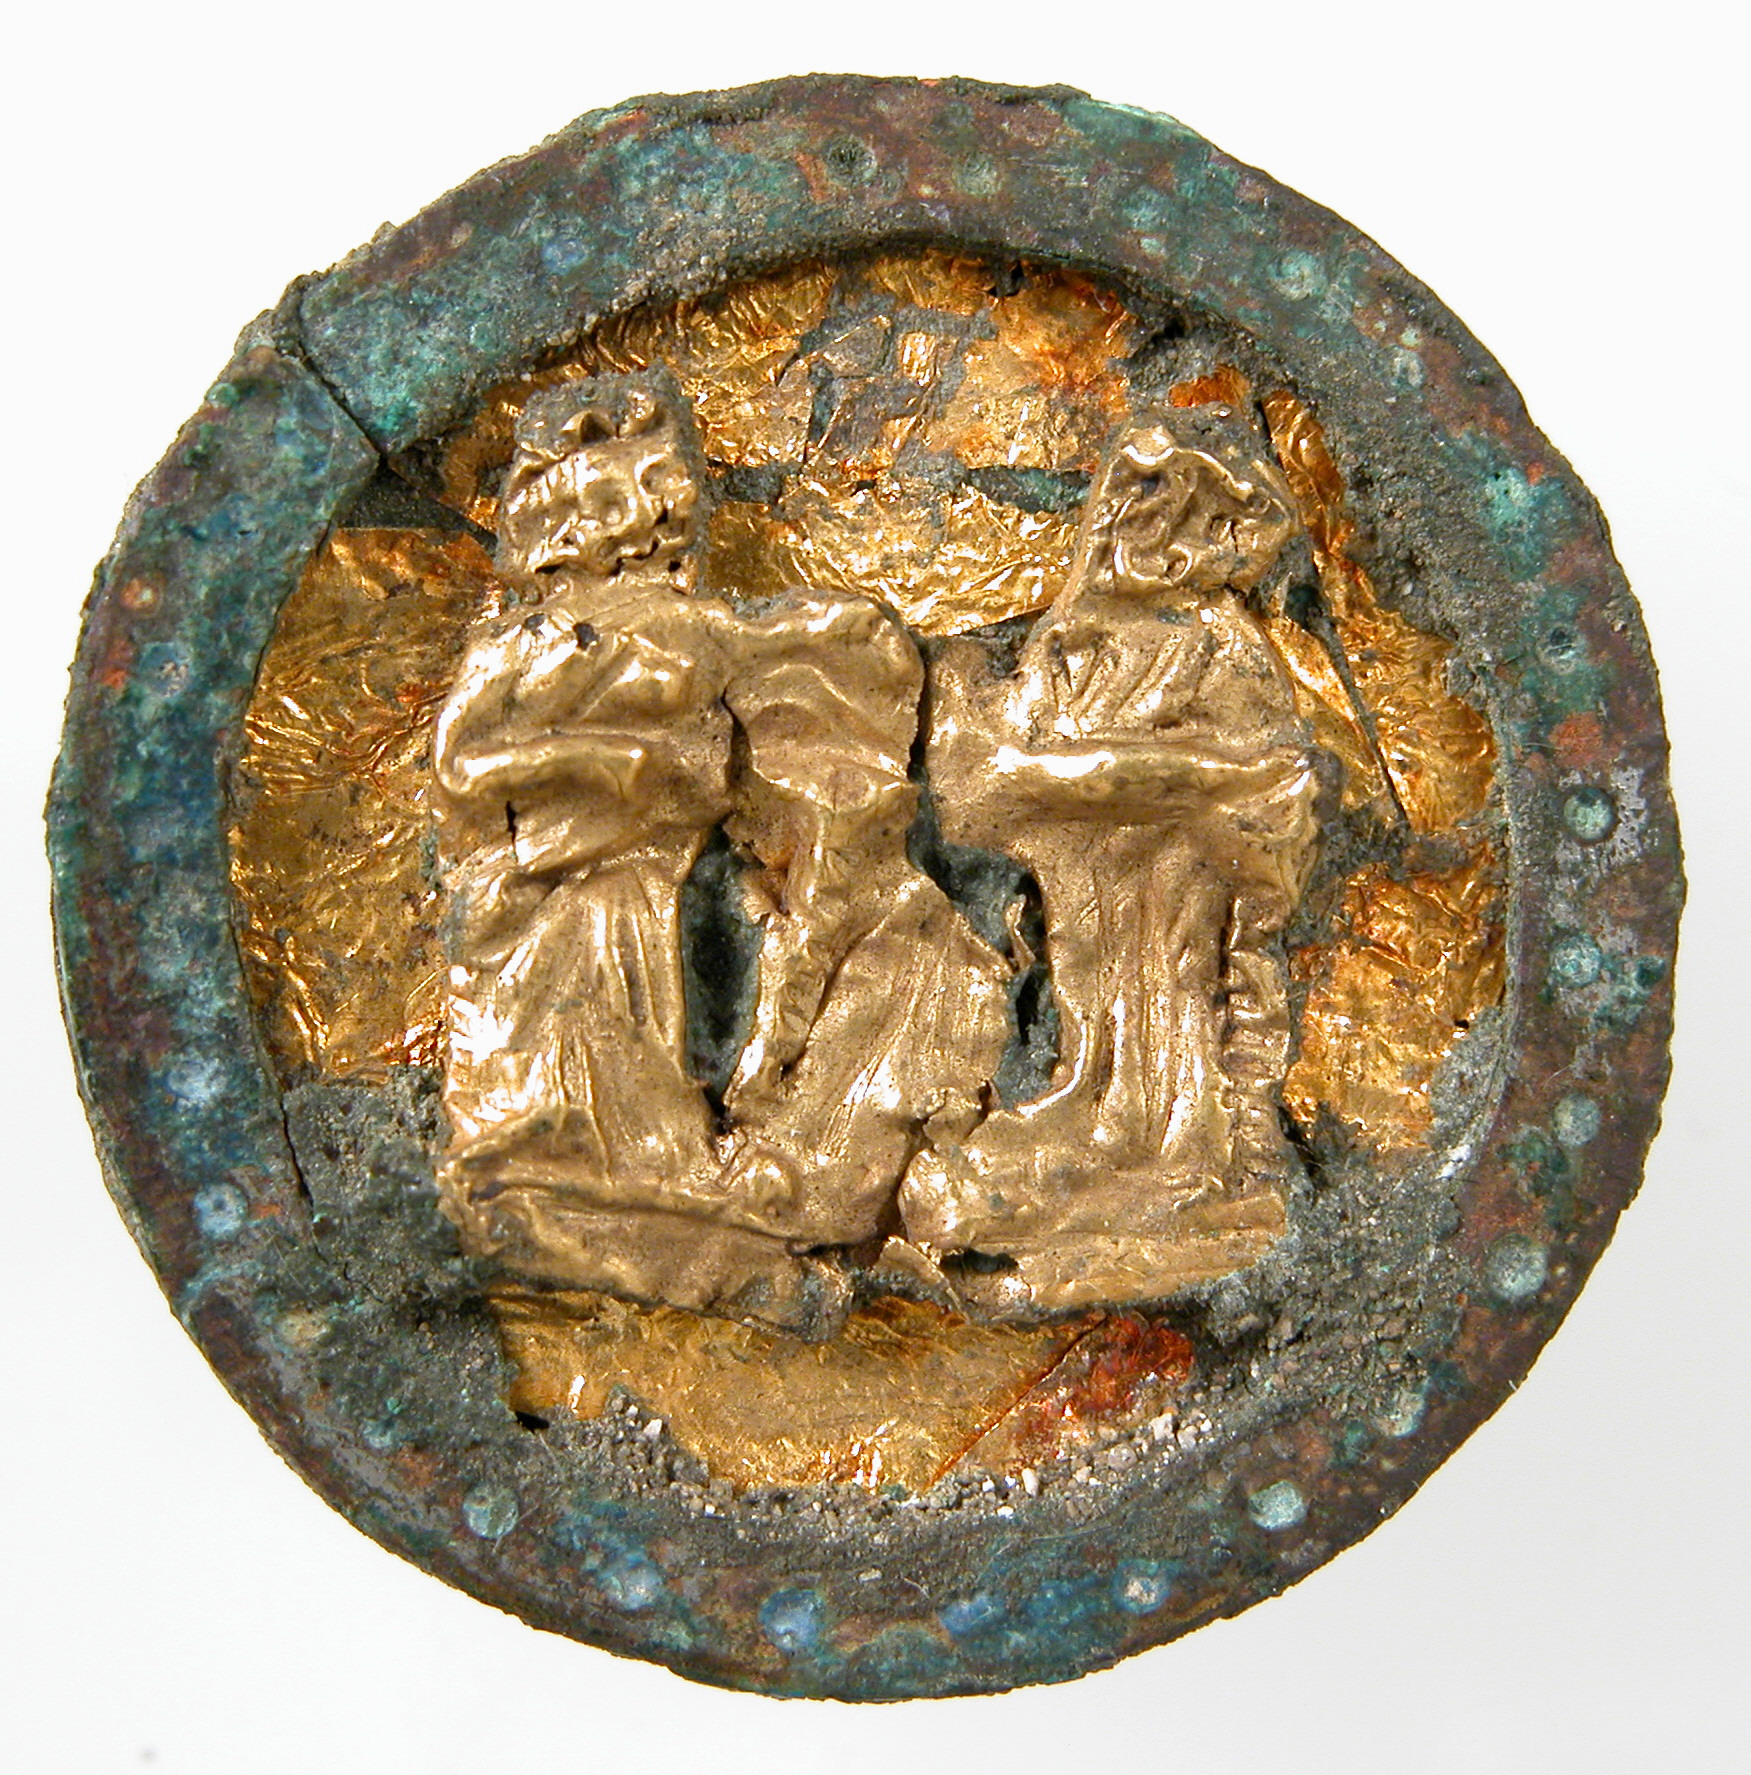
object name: bracteate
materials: bronze, gold, iron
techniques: silvered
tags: human figures